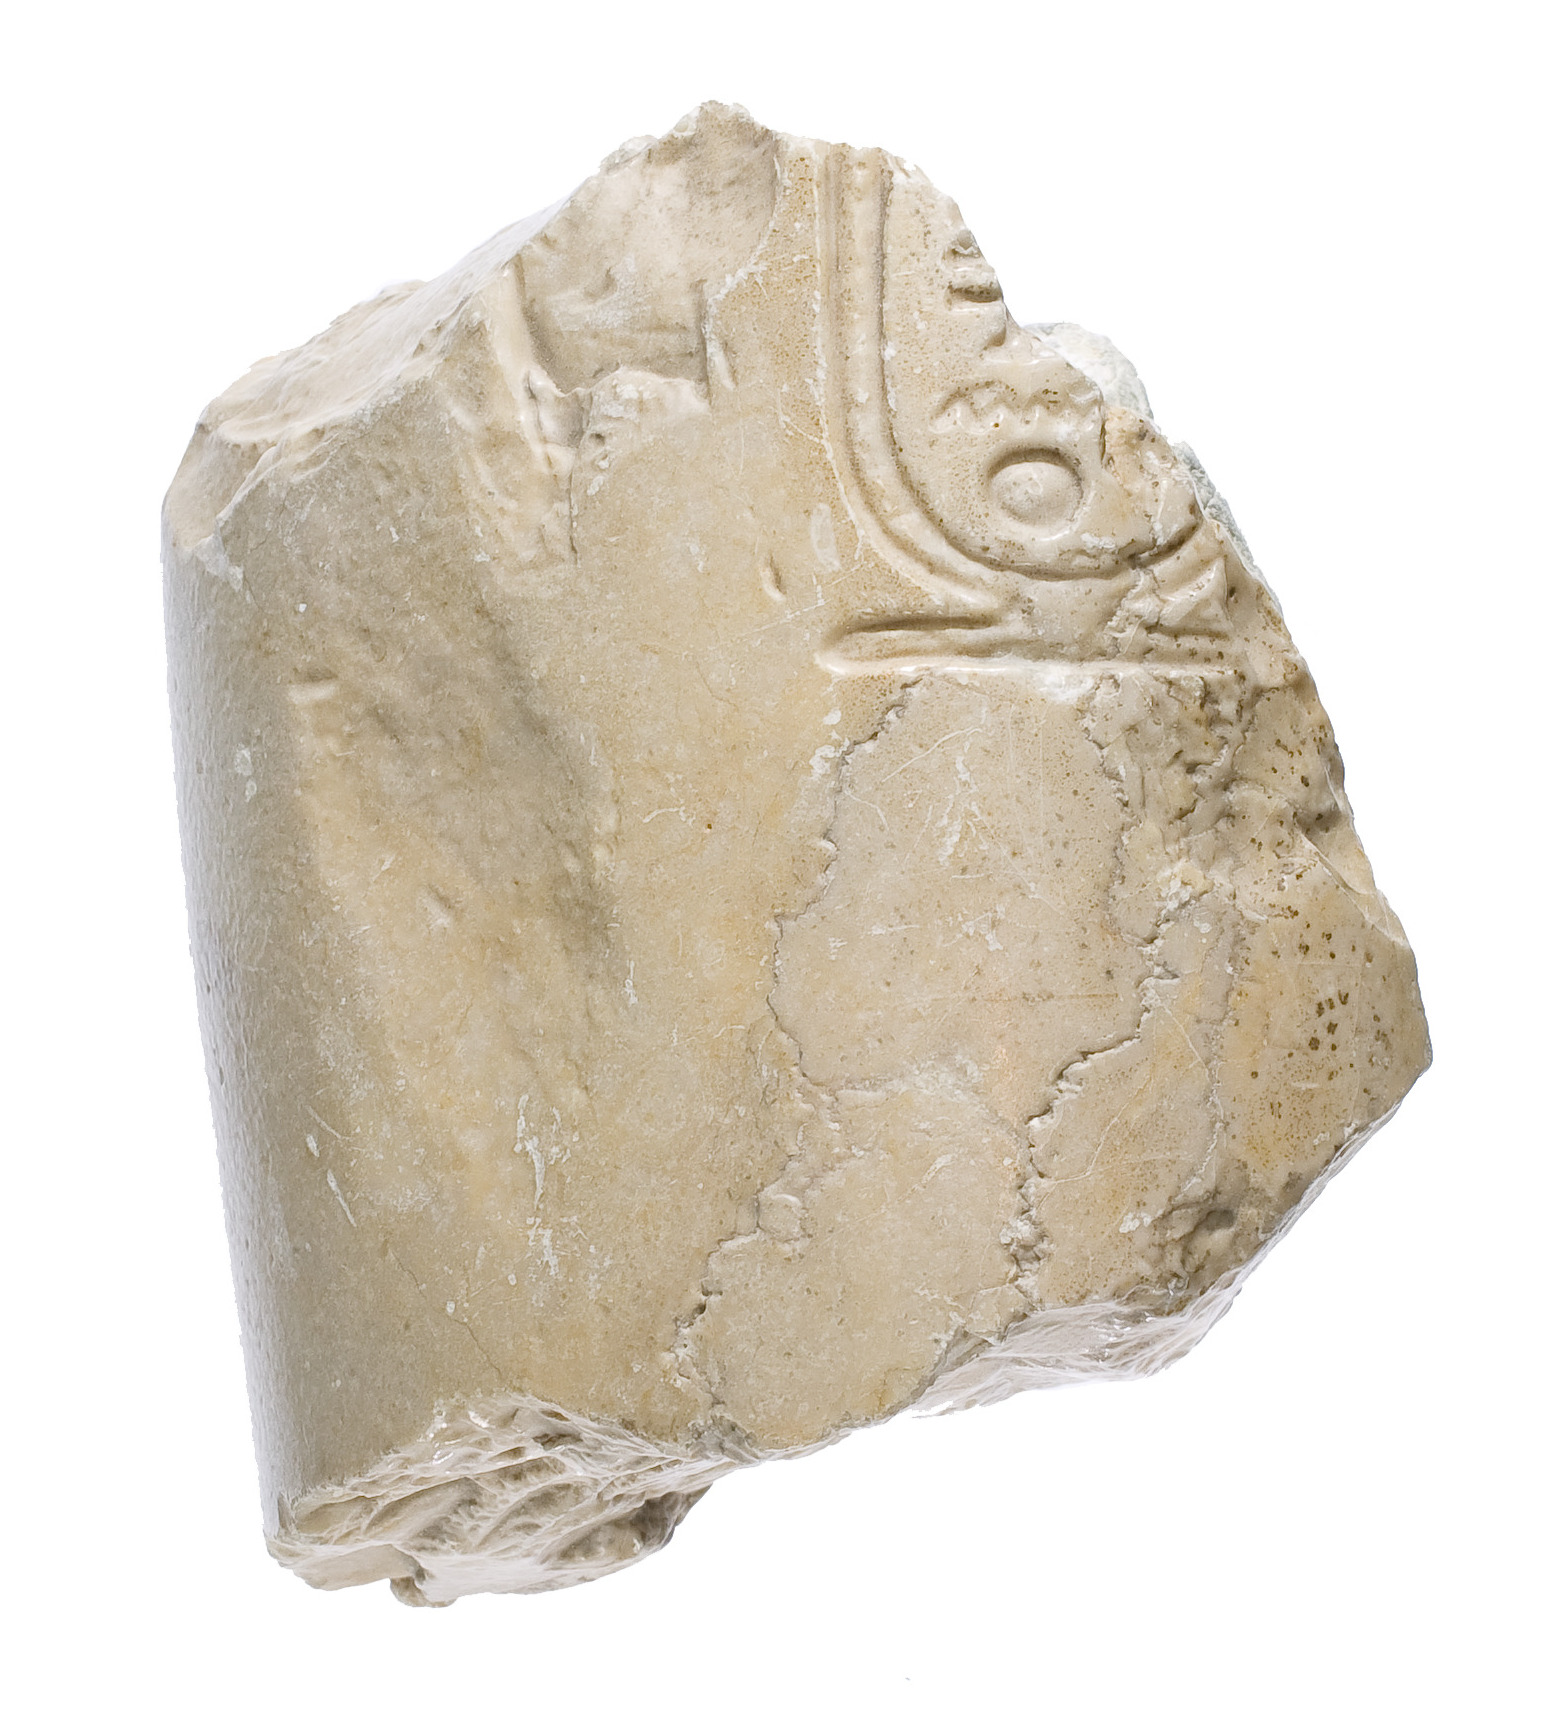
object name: arm at shoulder, aten cartouch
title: Arm, outside shoulder with Aten cartouche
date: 1353-1336 BCE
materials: limestone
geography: egypt